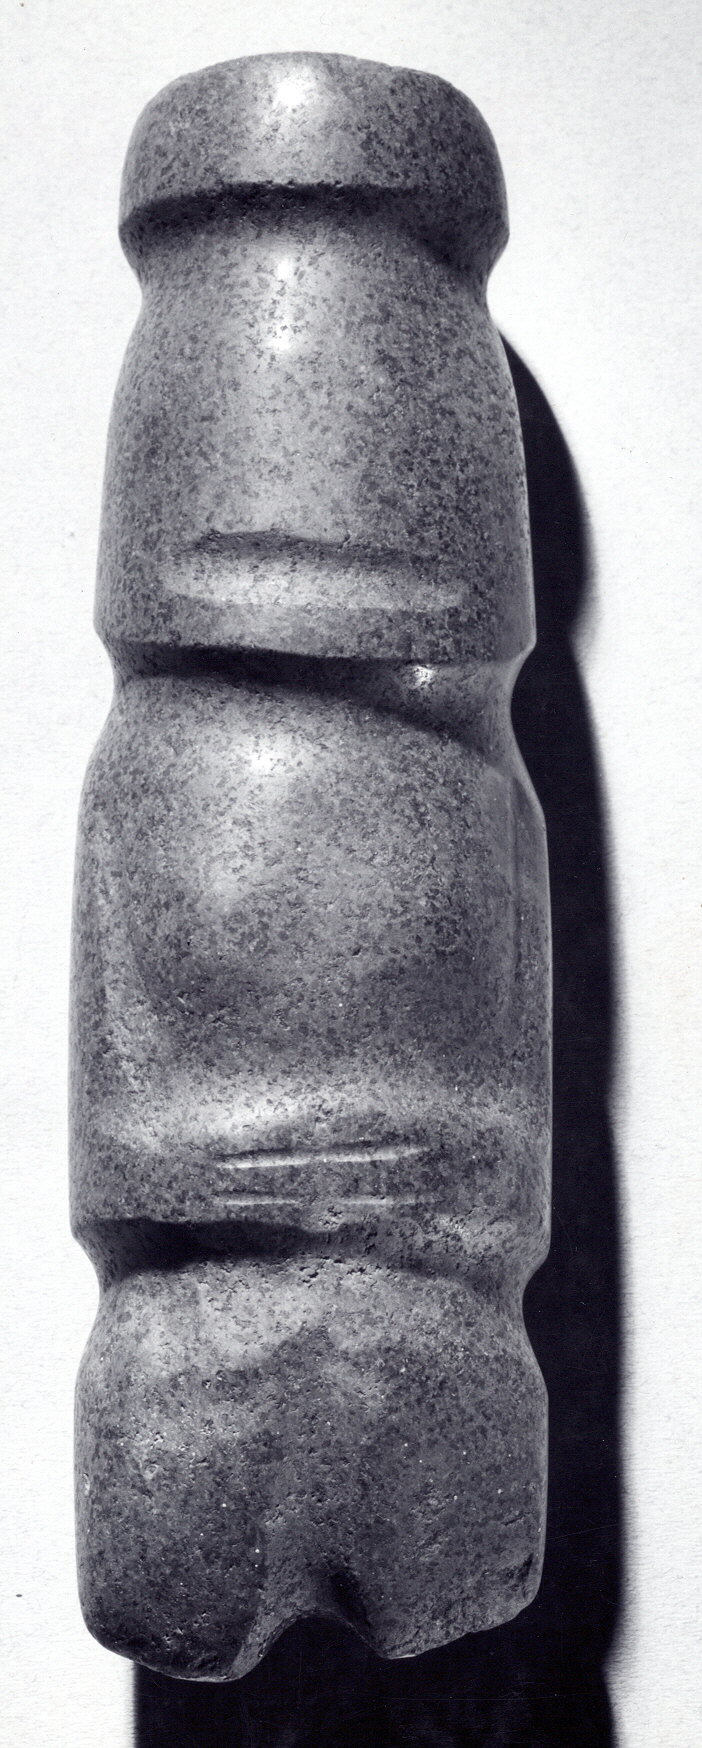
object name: figure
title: Stylized Figure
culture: mezcala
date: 1-800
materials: stone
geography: mexico